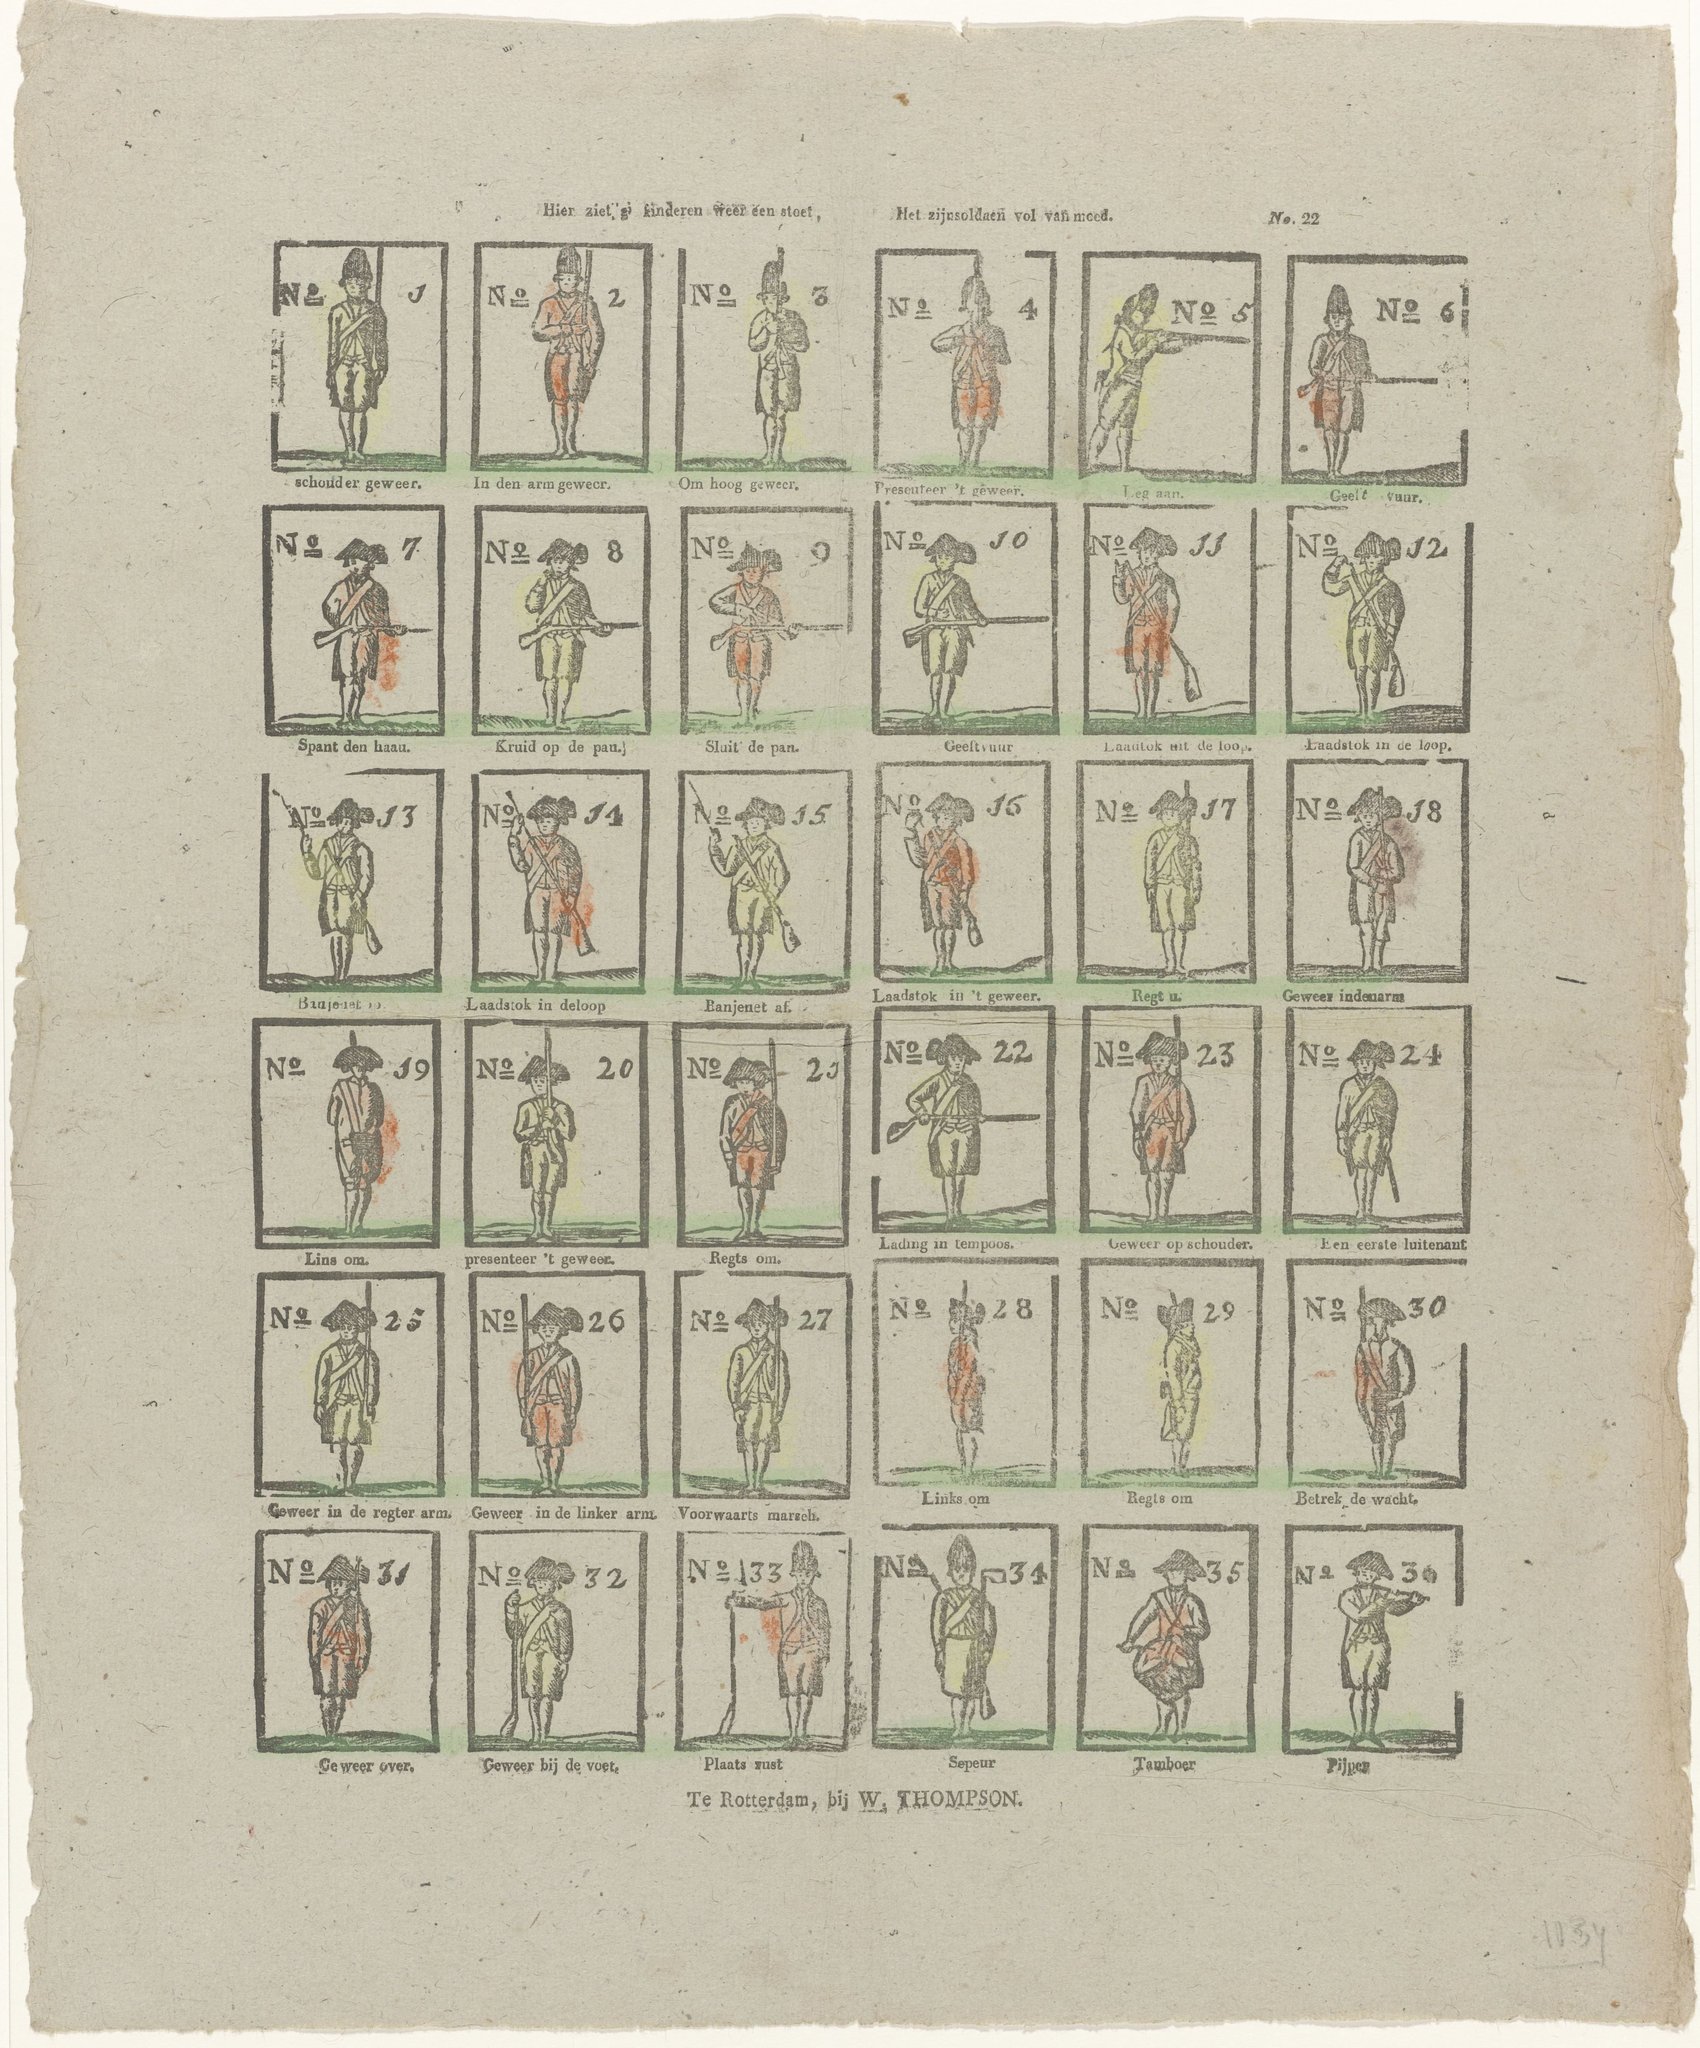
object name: popular print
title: Hier ziet gi kinderen weer een stoet, / Het zijnsoldaen vol van moed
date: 1835-1837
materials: paper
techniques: colour, letterpress printing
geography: rotterdam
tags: weapons, the soldier; the soldier's life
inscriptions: collector's mark: Lugt 2228, collector's mark: Lugt 2760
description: Blad met 36 genummerde voorstellingen van militairen tijdens verschillende fases van de militaire exercitie. Onder elke afbeelding een onderschrift. Genummerd rechtsboven: No. 22.